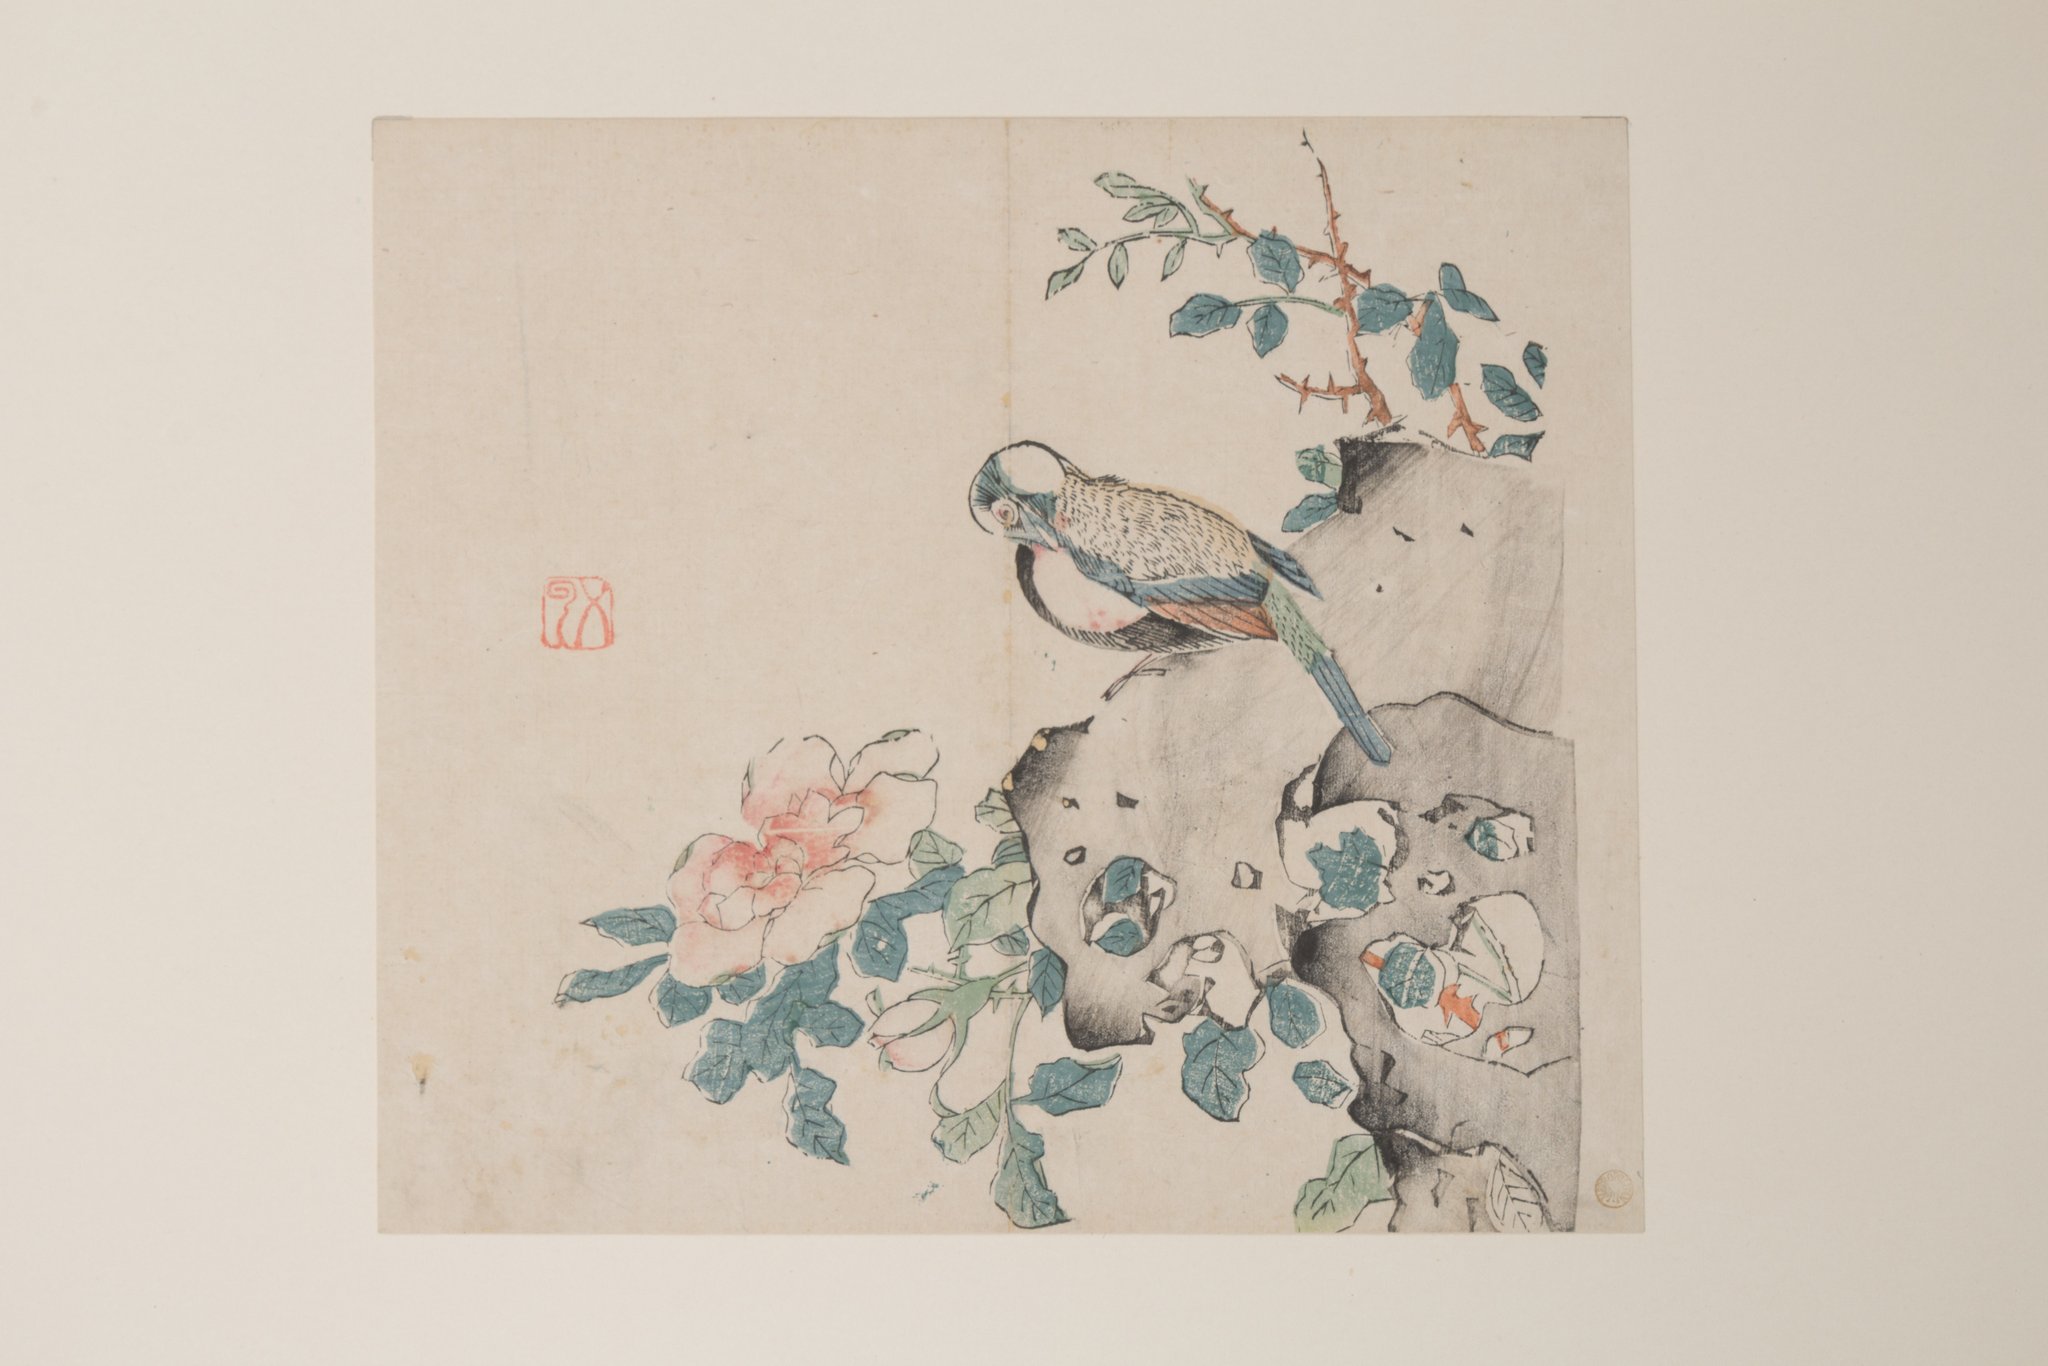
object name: print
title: Leaf from the Ten Bamboo Studio Manual of Painting and Calligraphy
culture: chinese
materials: ink, paper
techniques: printing